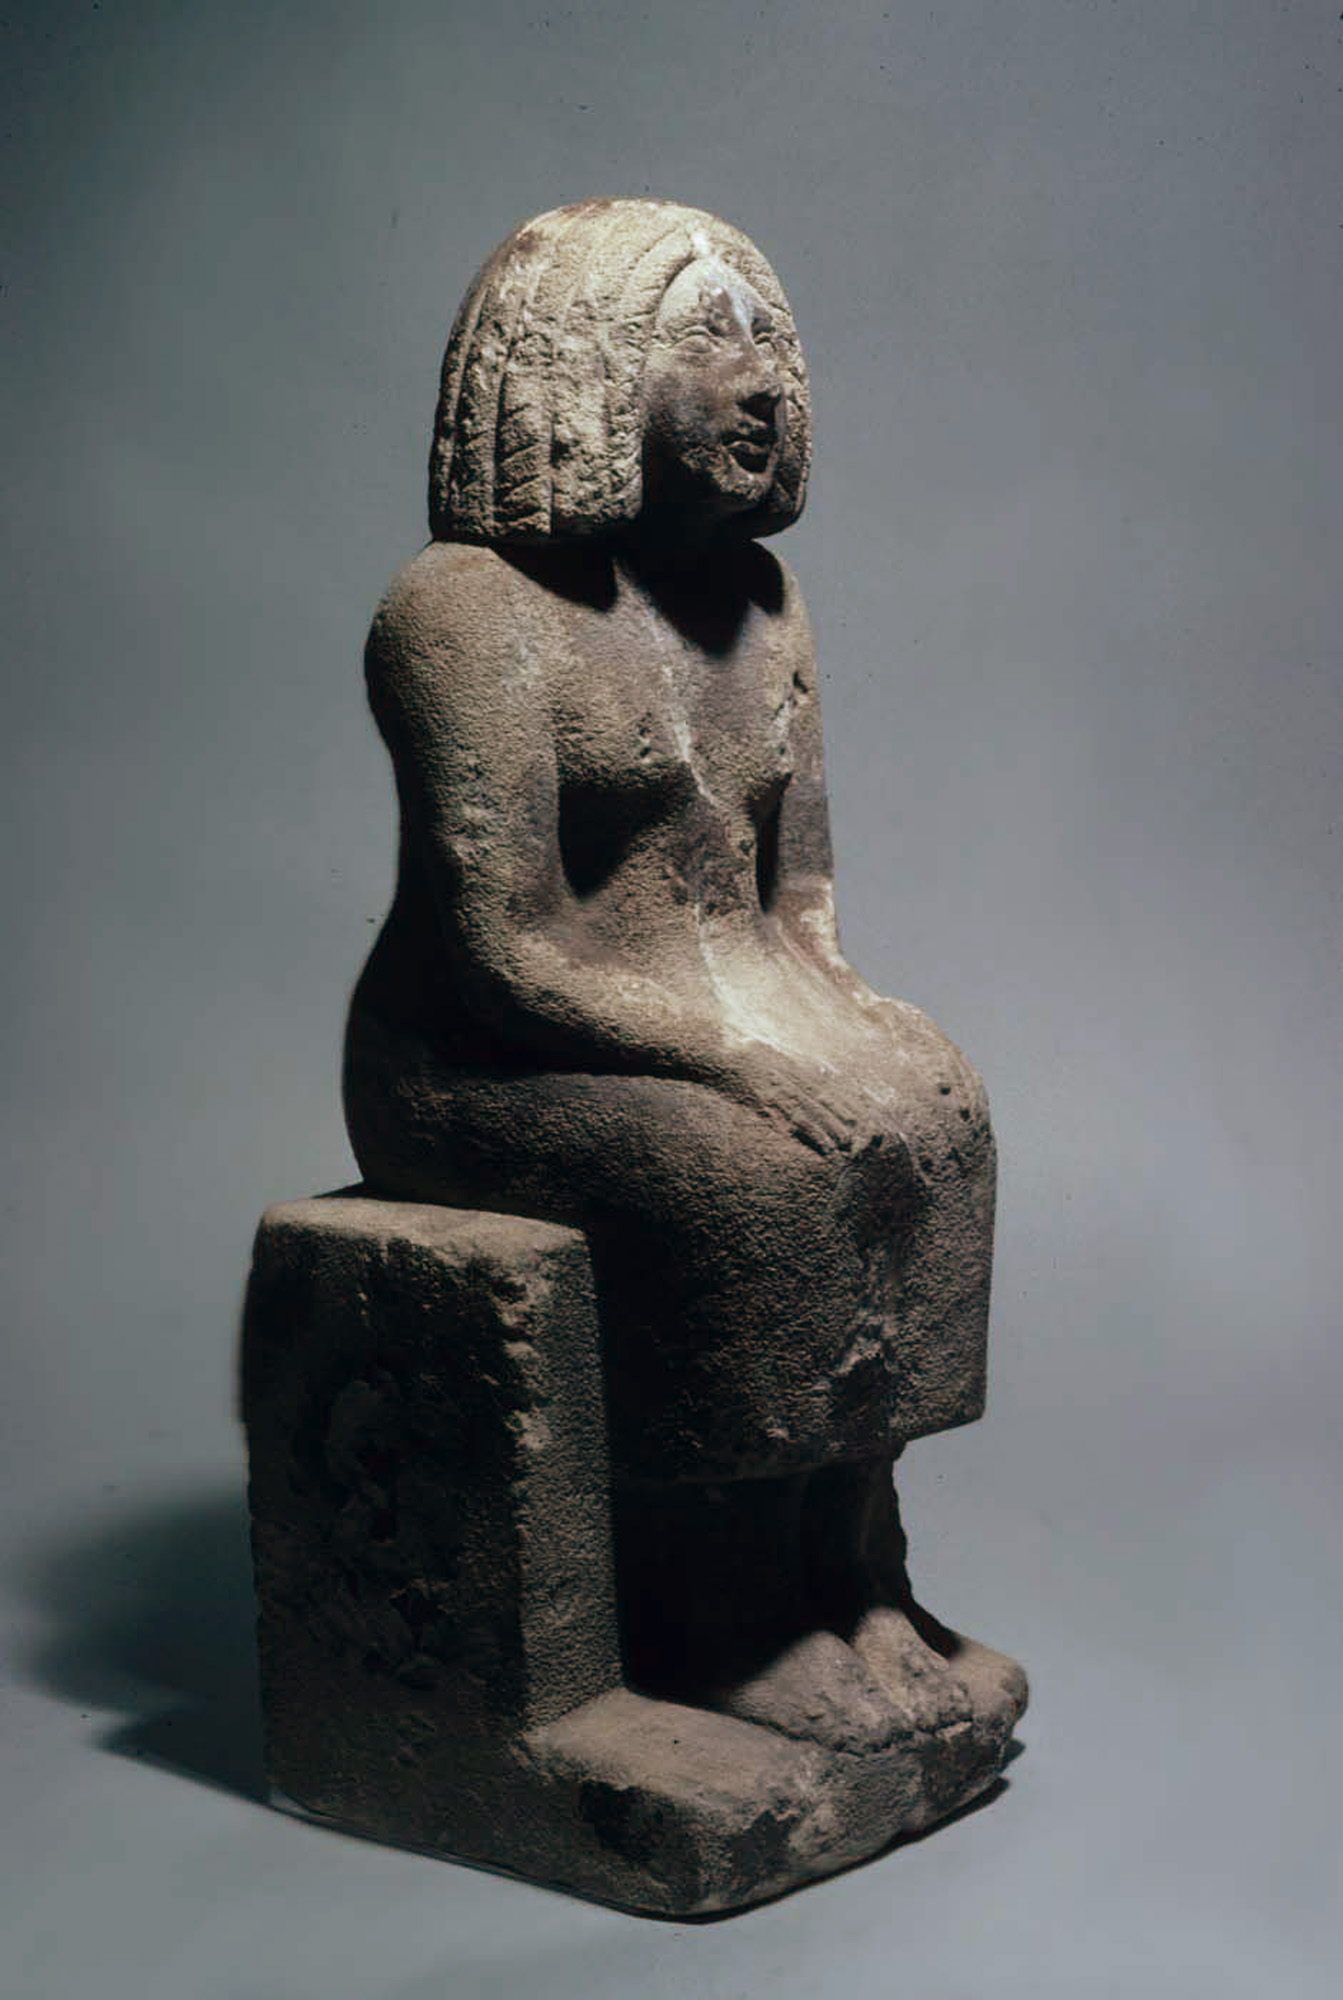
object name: statuette of a woman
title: Seated woman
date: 2465-2150 BCE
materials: limestone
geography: egypt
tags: women